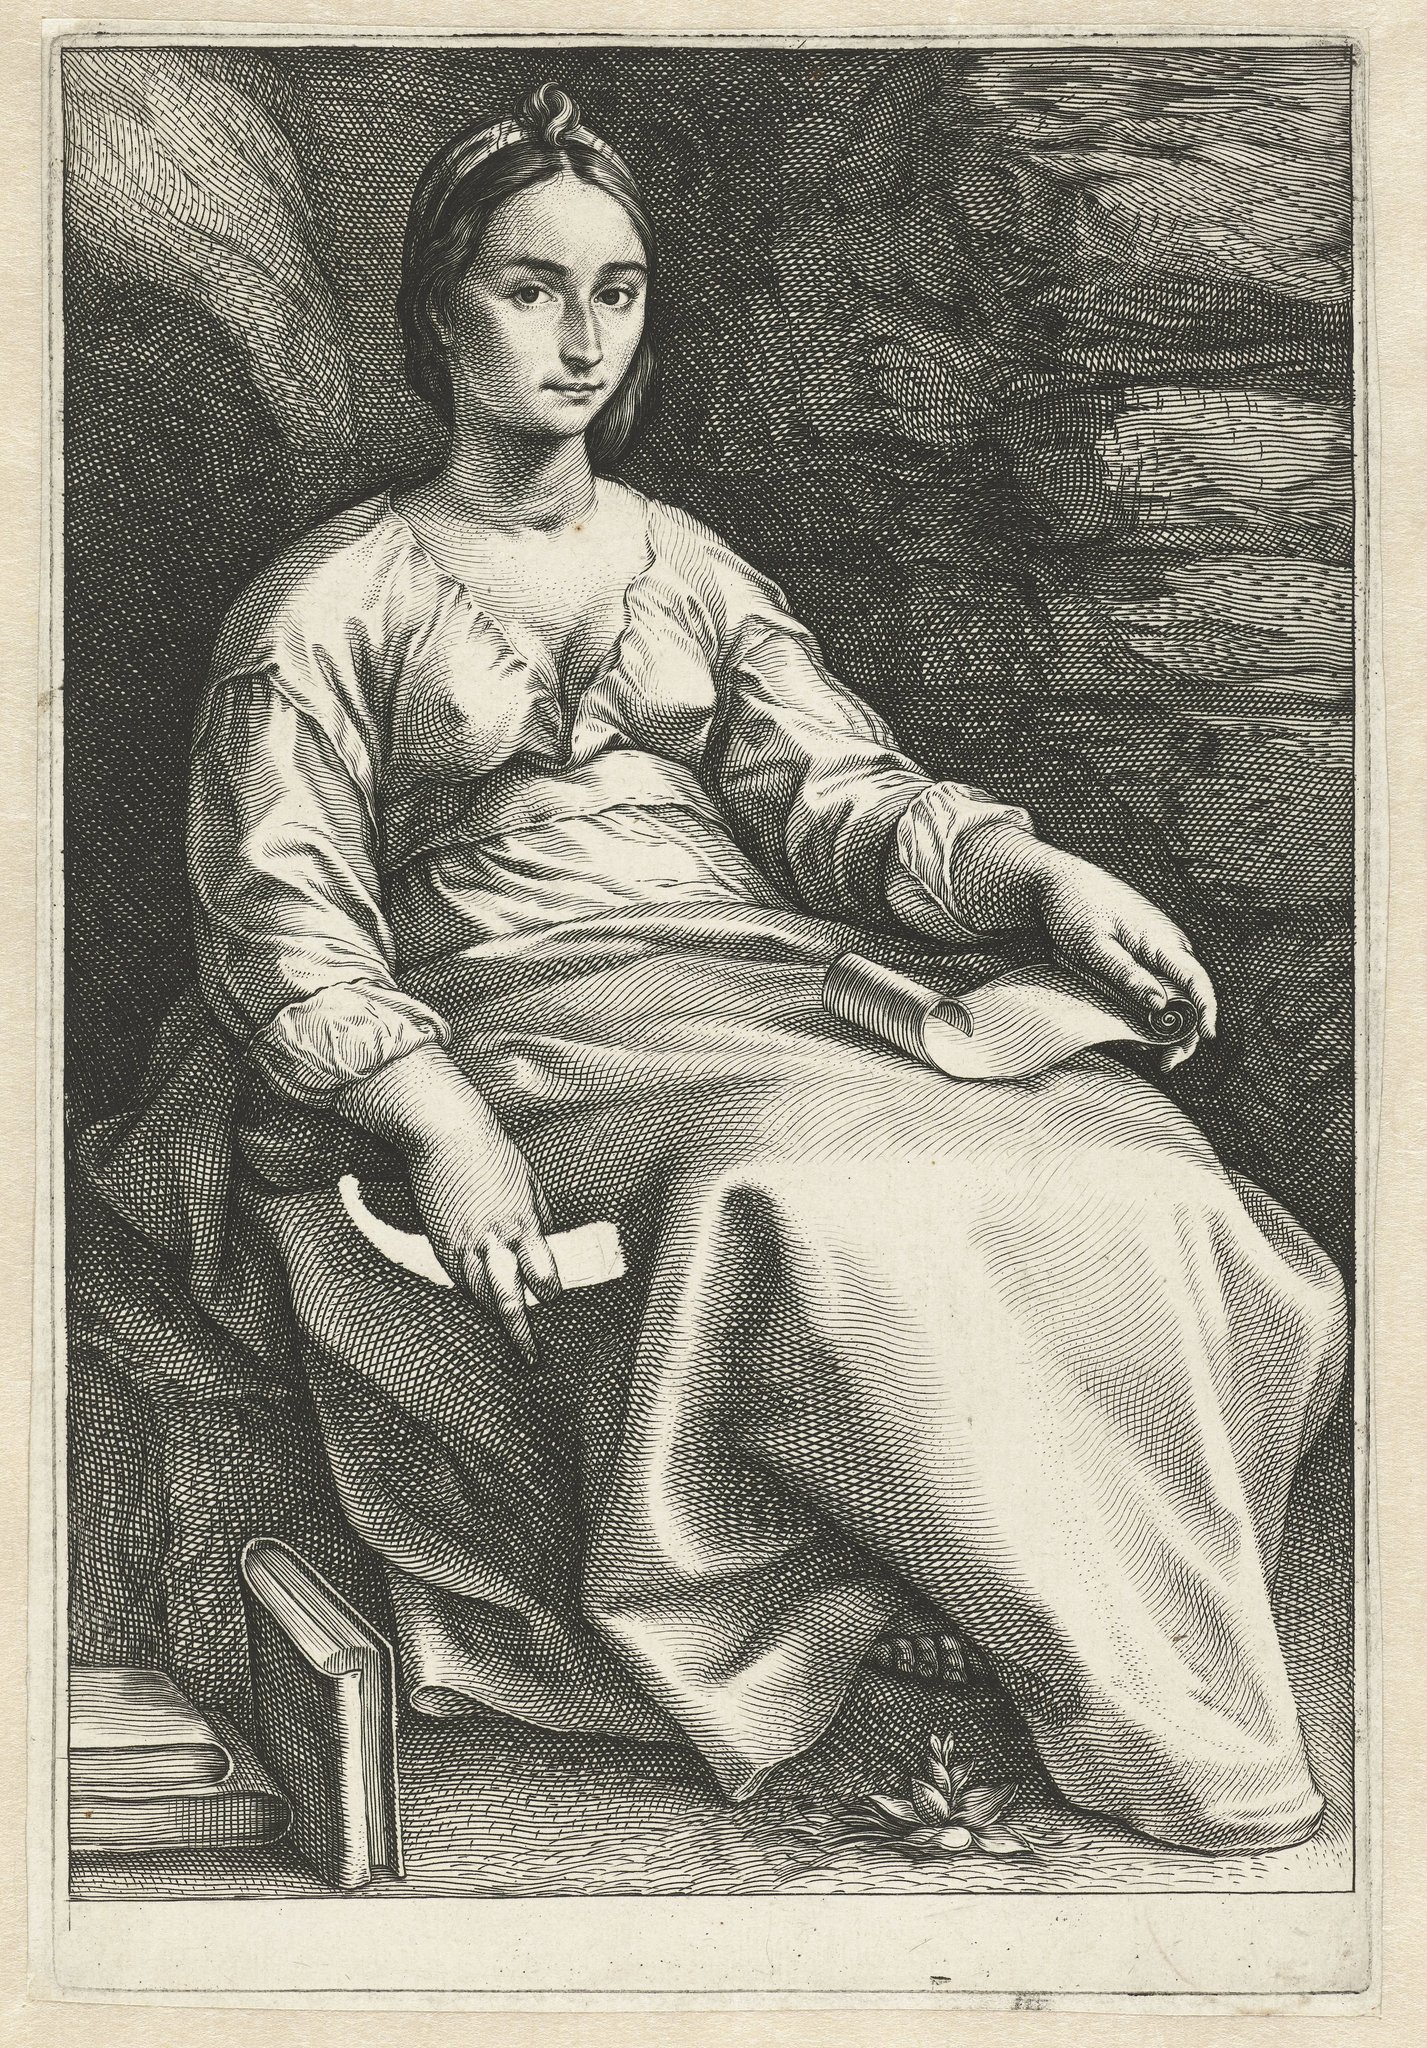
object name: print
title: De negen muzen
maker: hendrick goltzius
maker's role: draughtsman, painter, print maker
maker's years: 1558-1617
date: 1592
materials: paper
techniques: engraving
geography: haarlem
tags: melpomene (one of the muses); 'melpomene' (ripa)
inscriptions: collector's mark: Lugt 240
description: Een serie van negen muzen. Eerste staat, voor onderschriften.